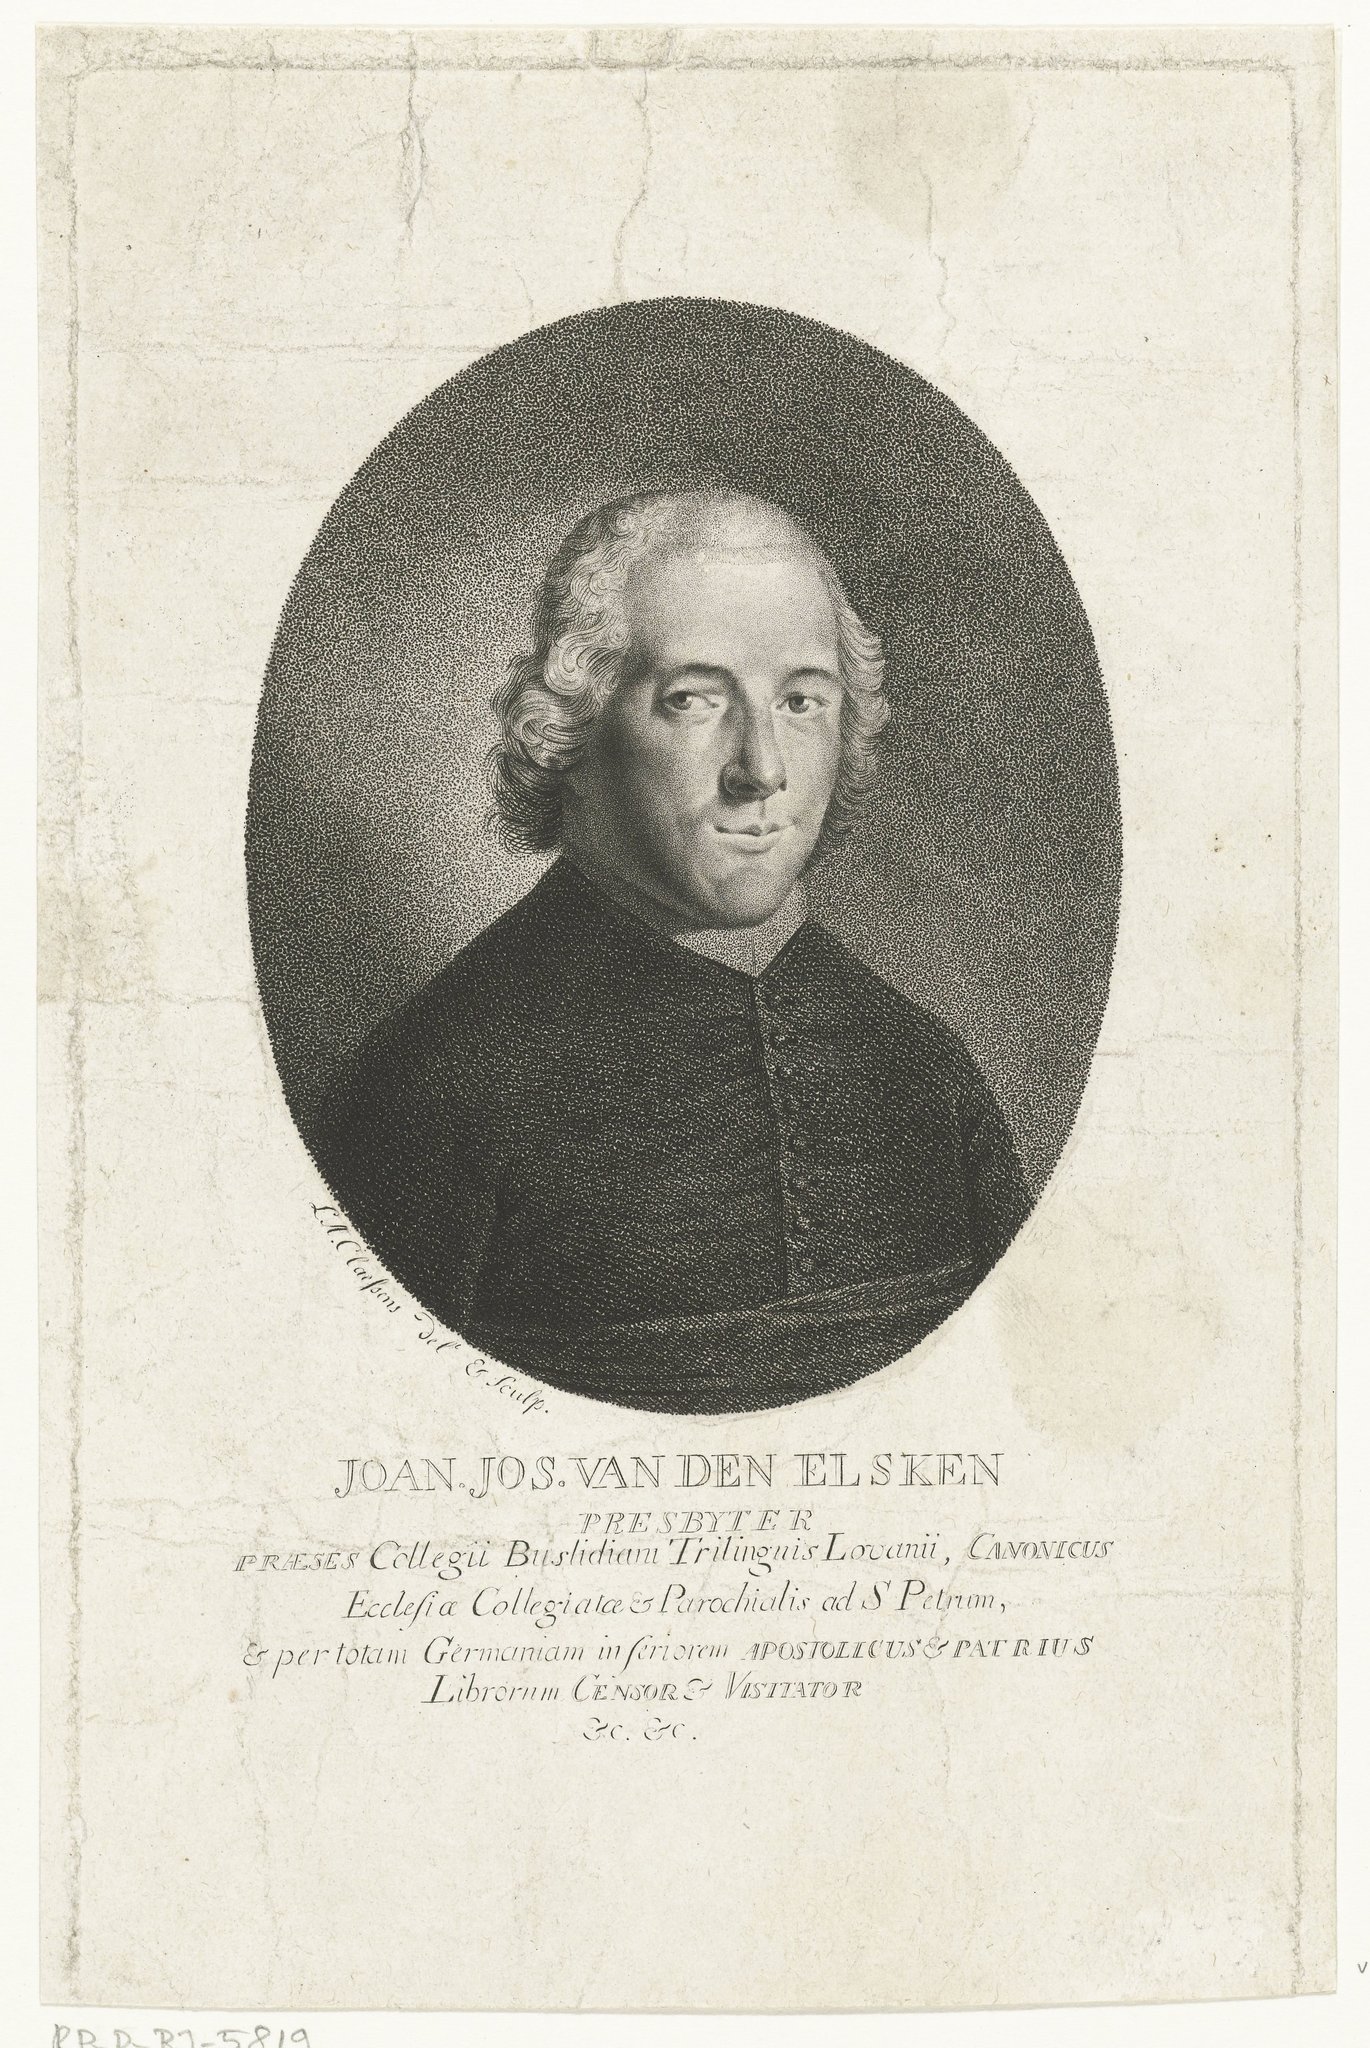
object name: print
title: Portret van Joan. Jos. van den Elsken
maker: lambertus antonius claessens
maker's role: draughtsman, print maker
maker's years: 1763-1834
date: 1792-1808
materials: paper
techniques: engraving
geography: amsterdam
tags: j.j. van den elsken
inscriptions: collector's mark: Lugt 2228